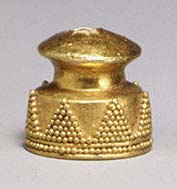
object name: cylinder seal cap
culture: babylonian or kassite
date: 1700-1501 BCE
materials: gold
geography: mesopotamia